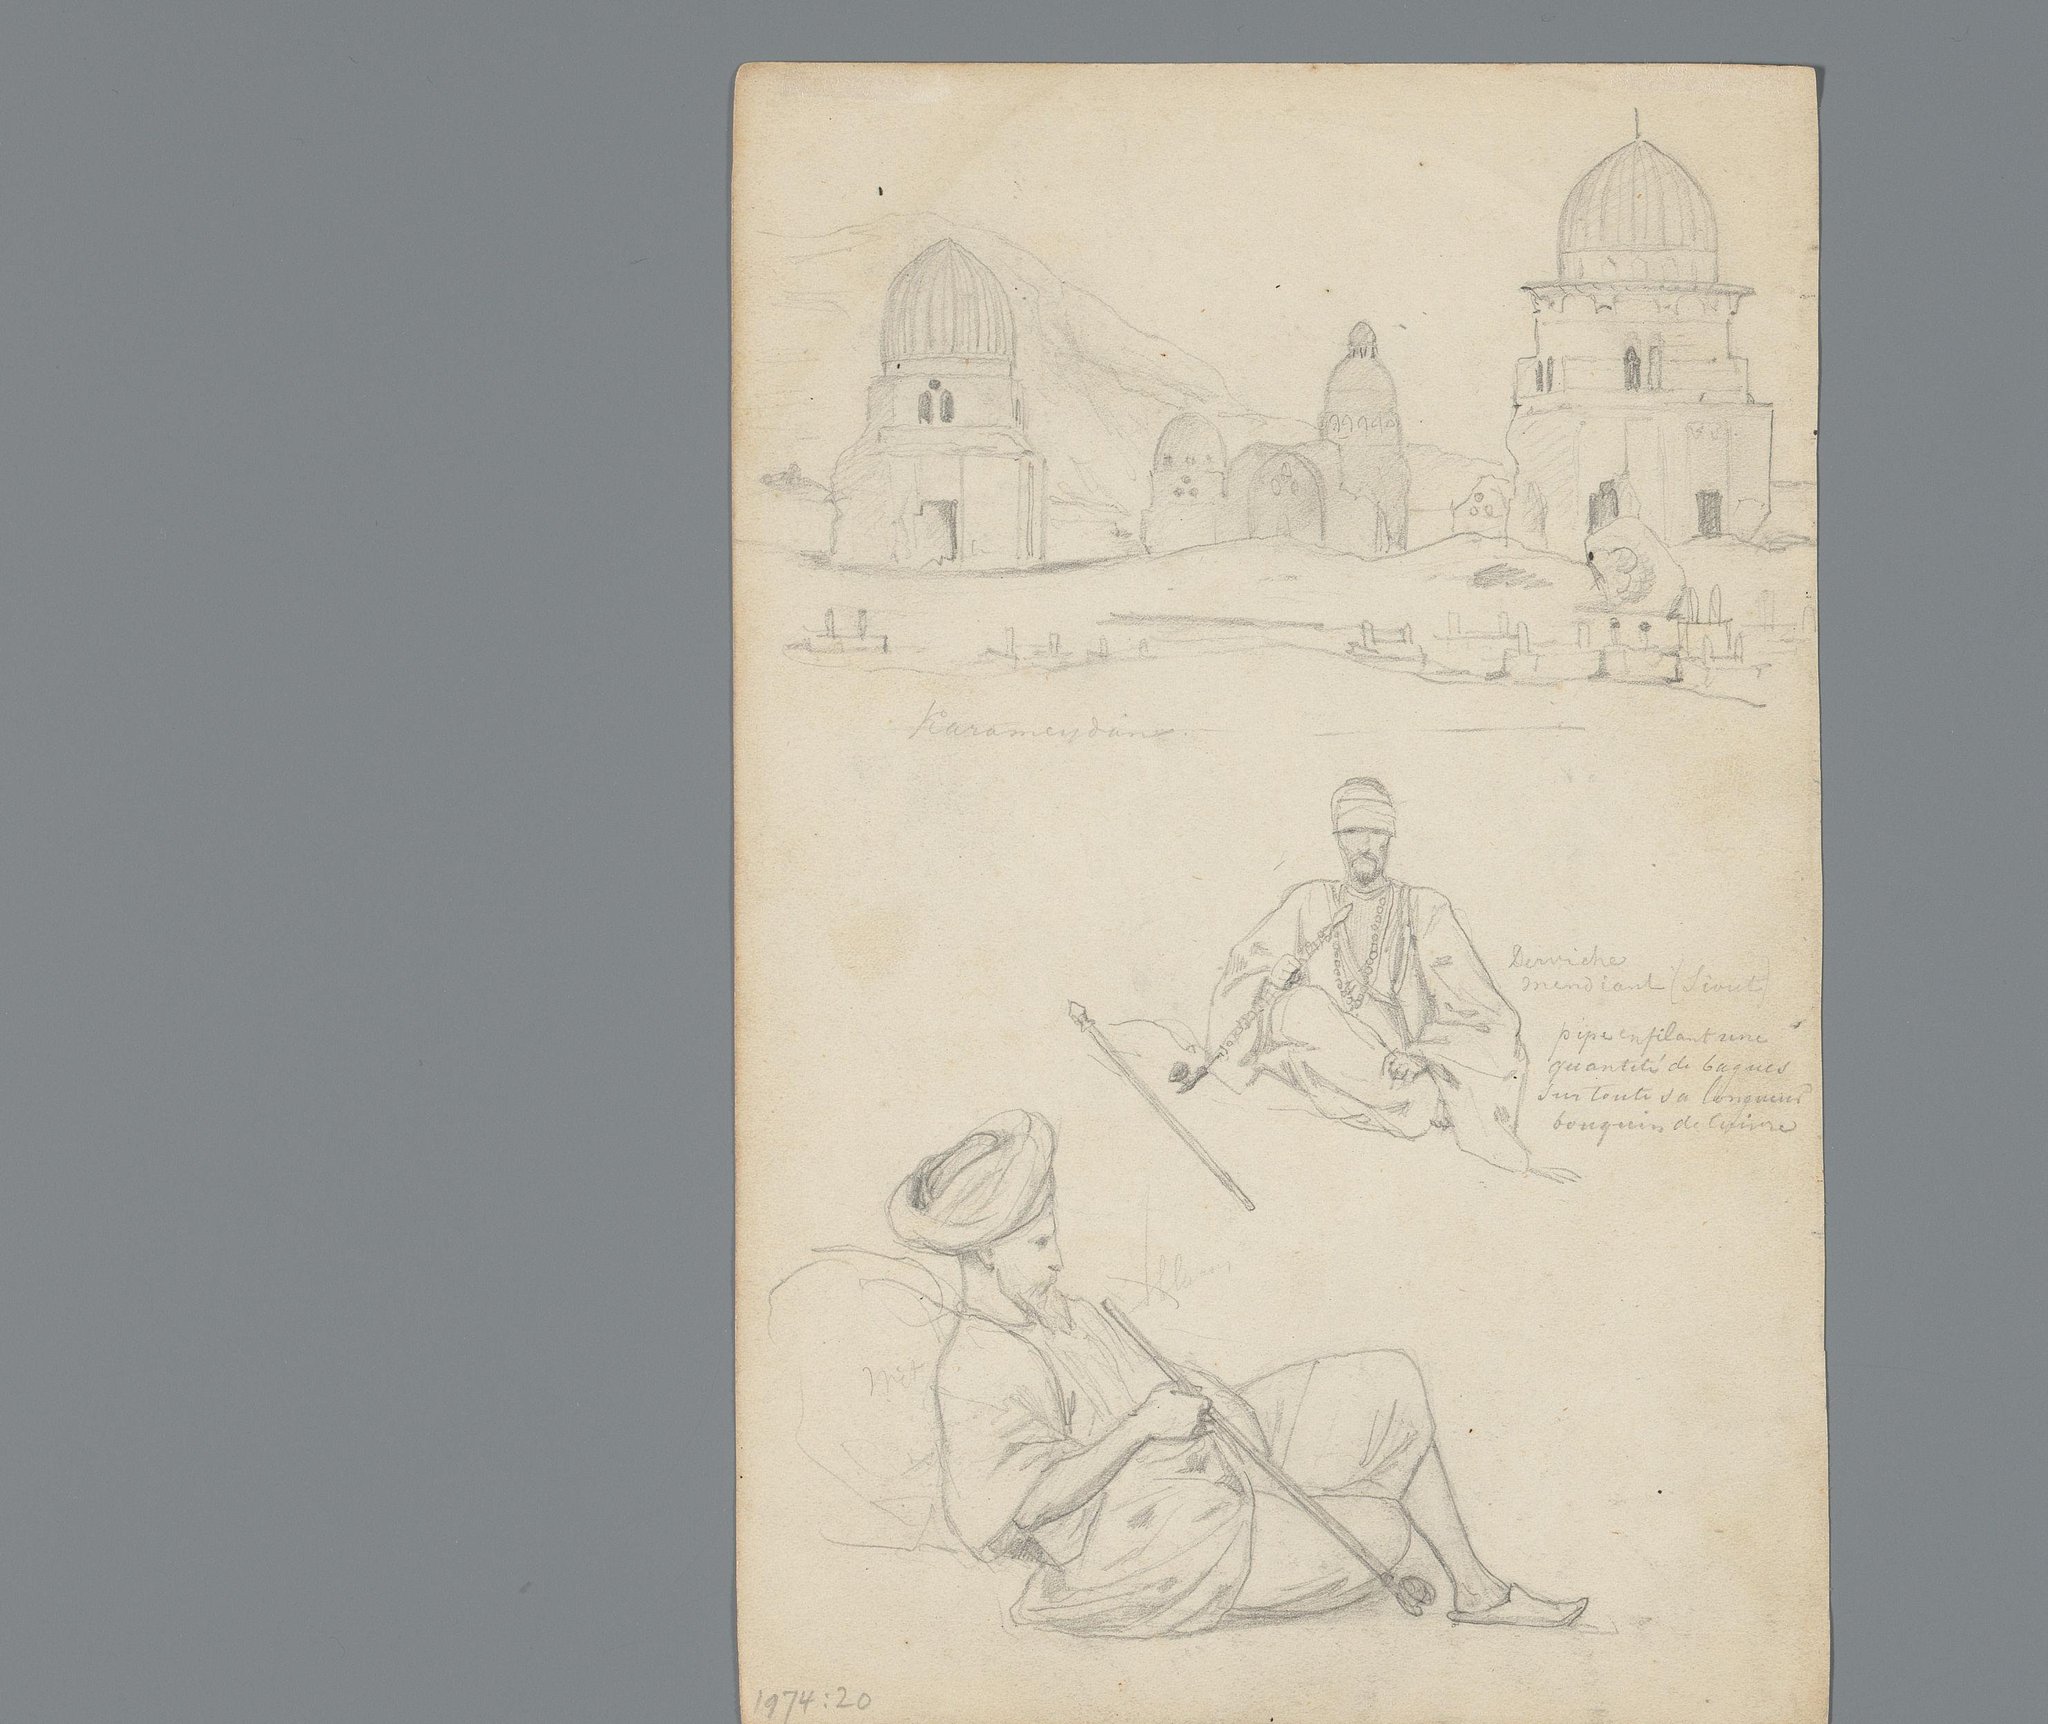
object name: drawing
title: Compositie met gebouwen en rokende Egyptenaren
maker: willem de famars testas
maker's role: draughtsman, painter, print maker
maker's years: 1834-1896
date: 1858-1859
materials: paper, pencil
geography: egypt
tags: pipe ~ tobacco, façade (of house or building)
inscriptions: inscription: ‘Karamandan / Derviche / mendiant (...) bouquin de cuisine’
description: Onderdeel van 20 losse bladen met tekeningen gemaakt tijdens Famars Testas zijn Egyptische reis van 1858, met voornamelijk figuren en dorpsgezichten met notities.